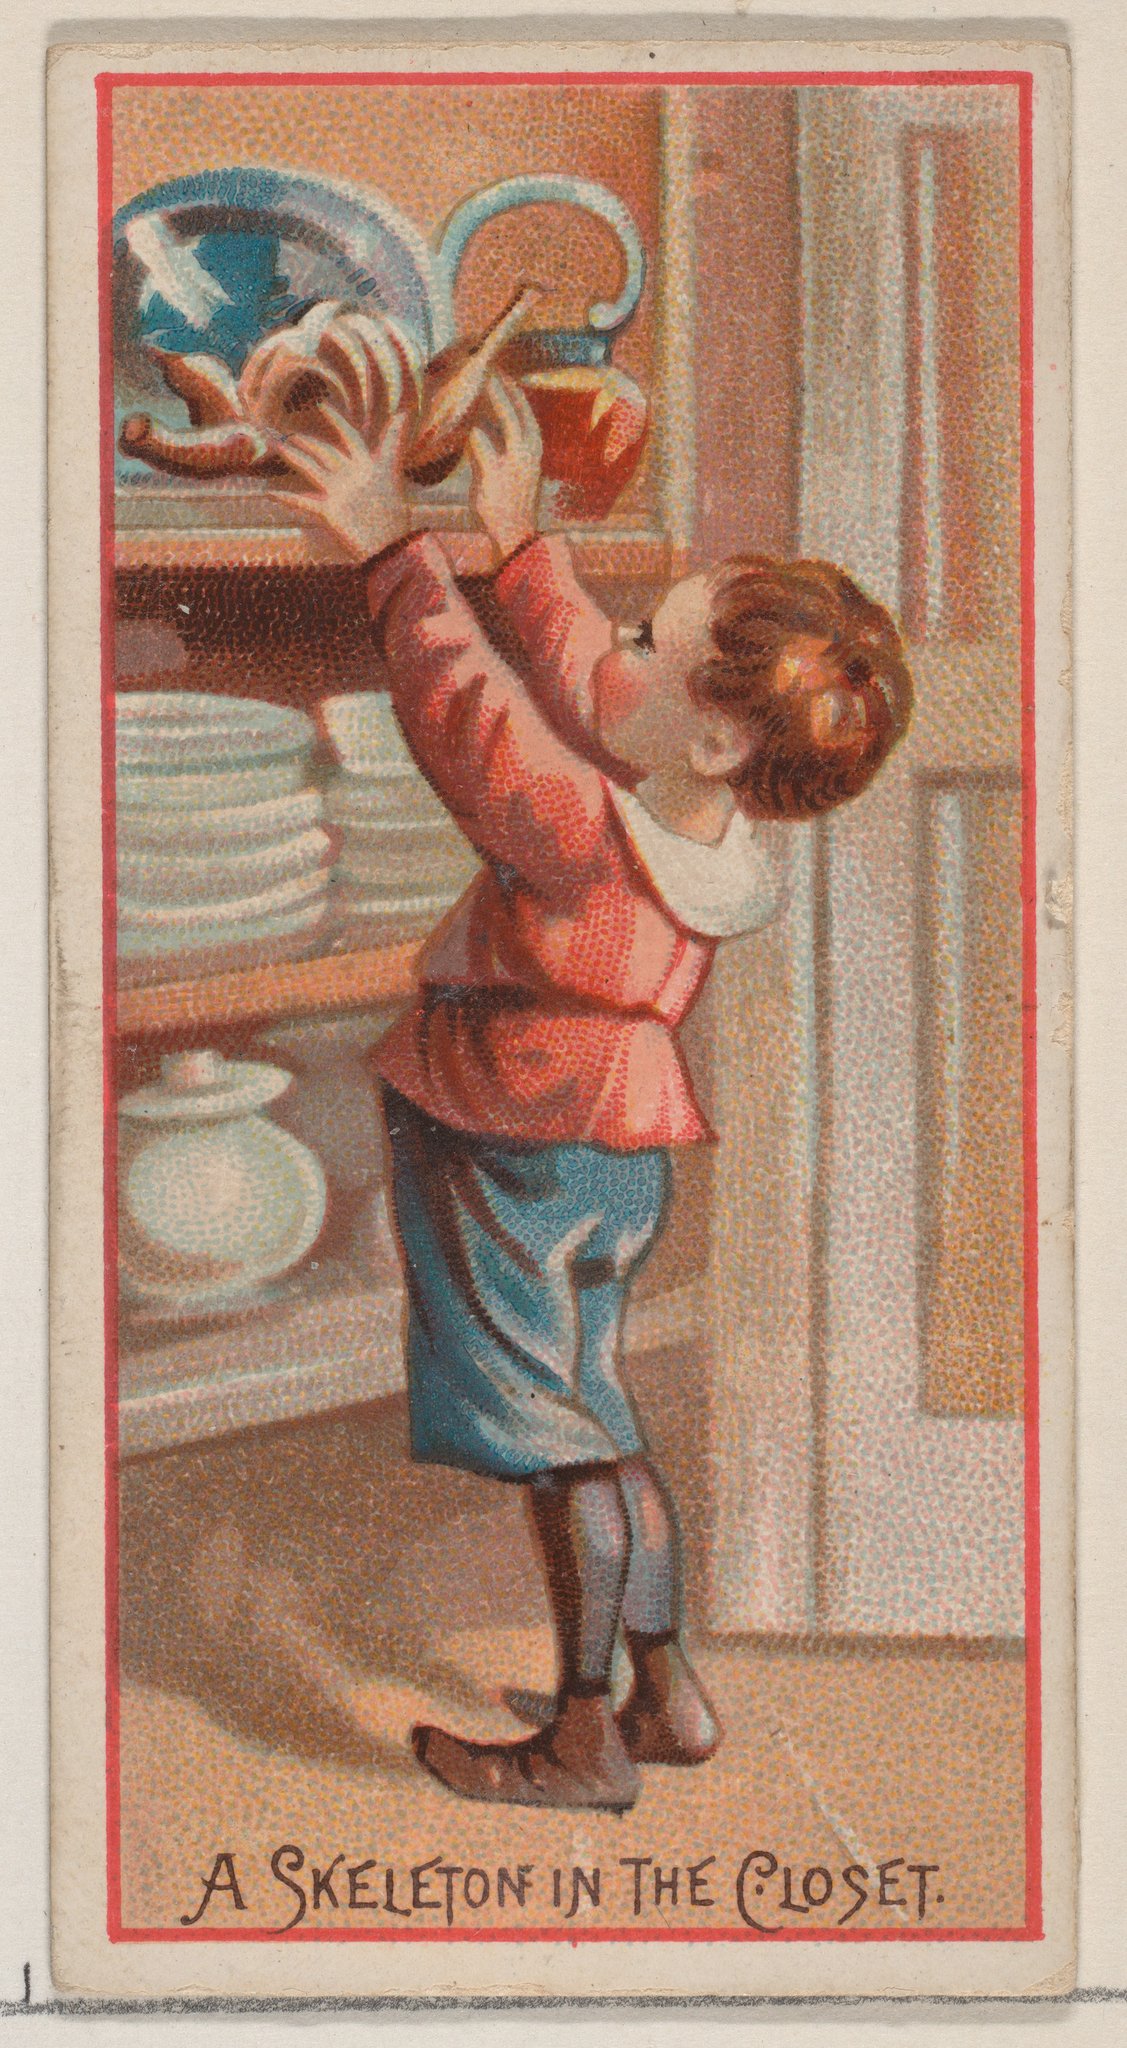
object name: print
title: A Skeleton in the Closet, from the Jokes series (N87) for Duke brand cigarettes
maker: w. duke, sons & co.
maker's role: publisher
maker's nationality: american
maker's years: 1870-1920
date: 1890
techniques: color lithograph